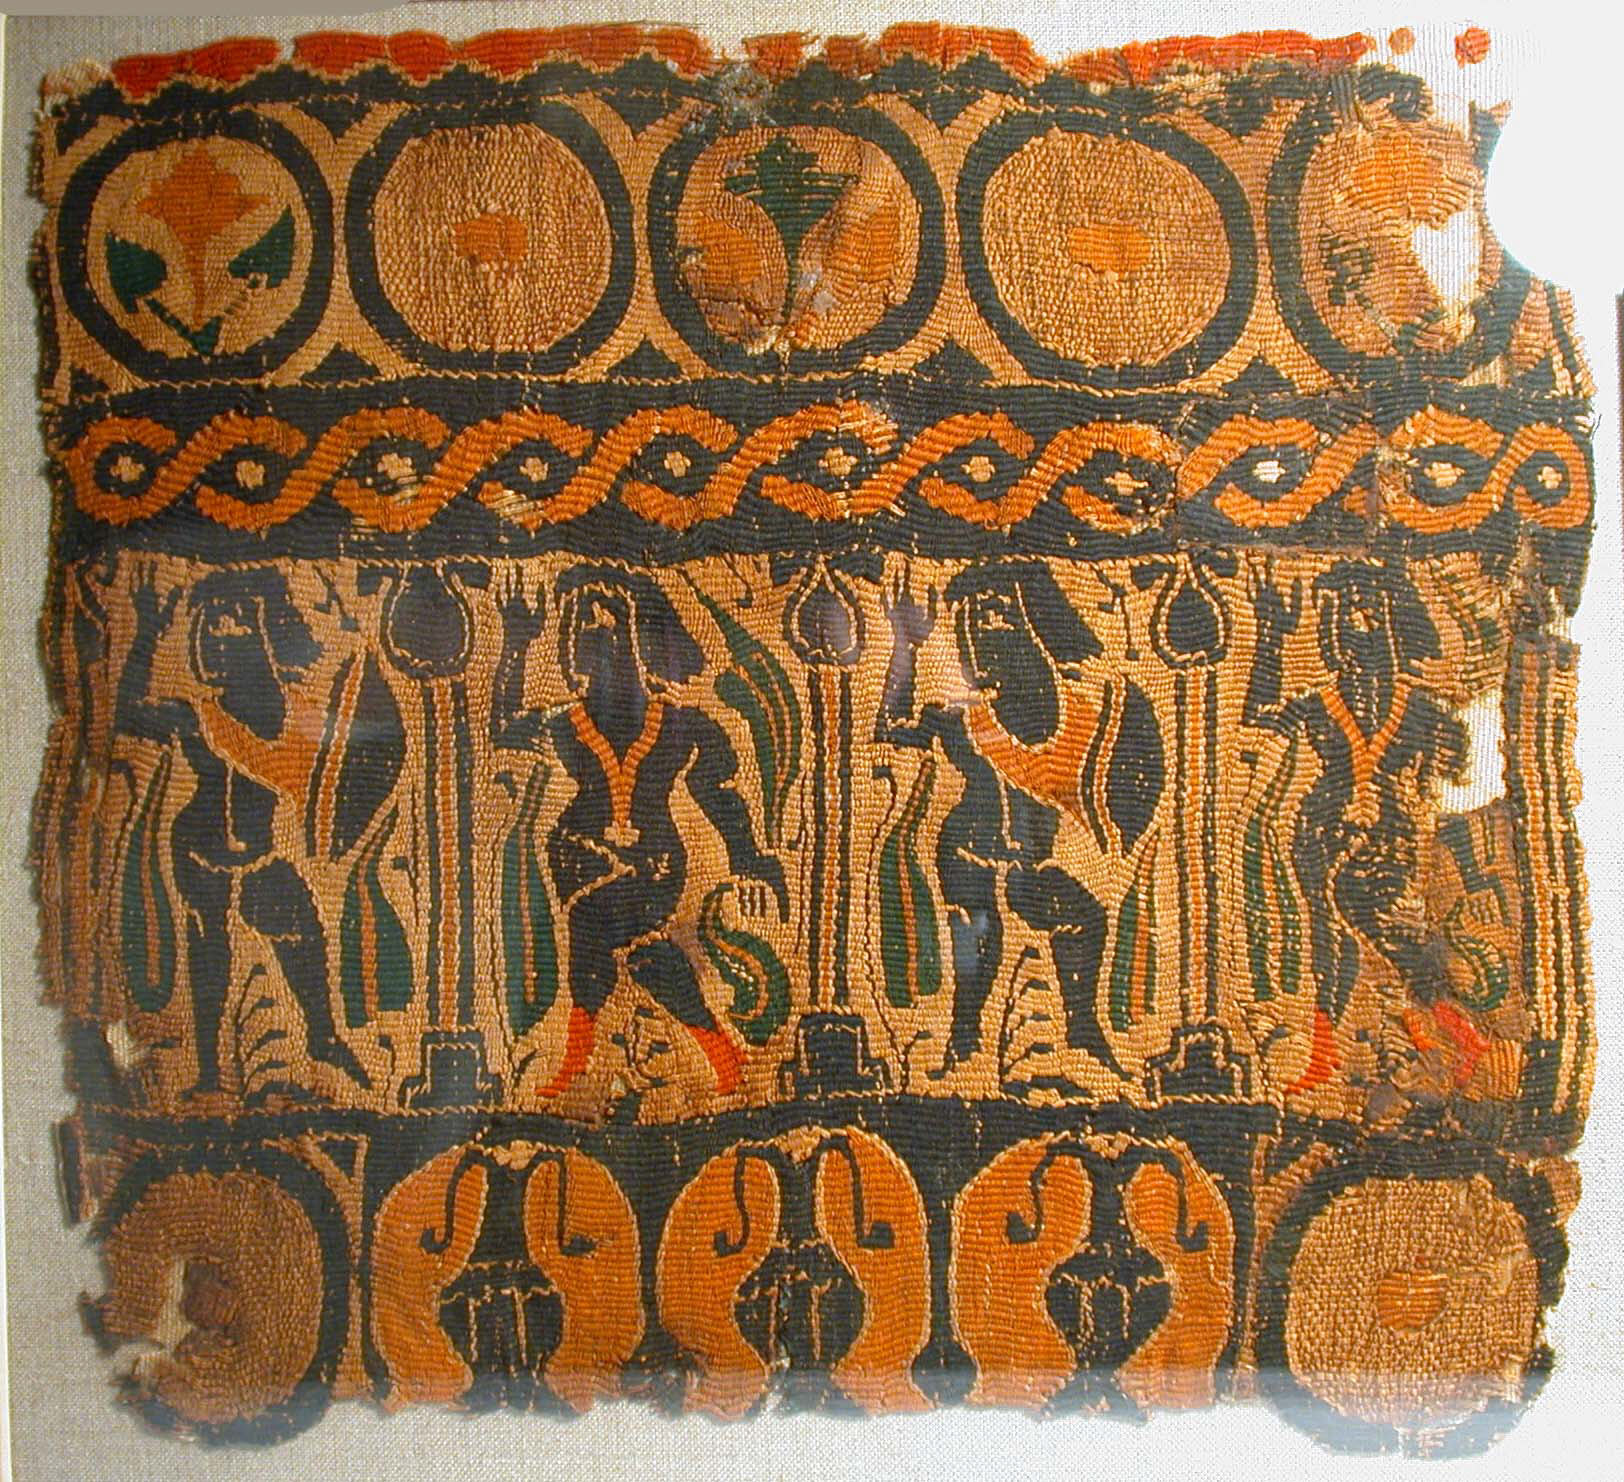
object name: textile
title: Four standing figures in an arcade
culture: early byzantine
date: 301-500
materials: linen, wool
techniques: polychrome, weave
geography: egypt